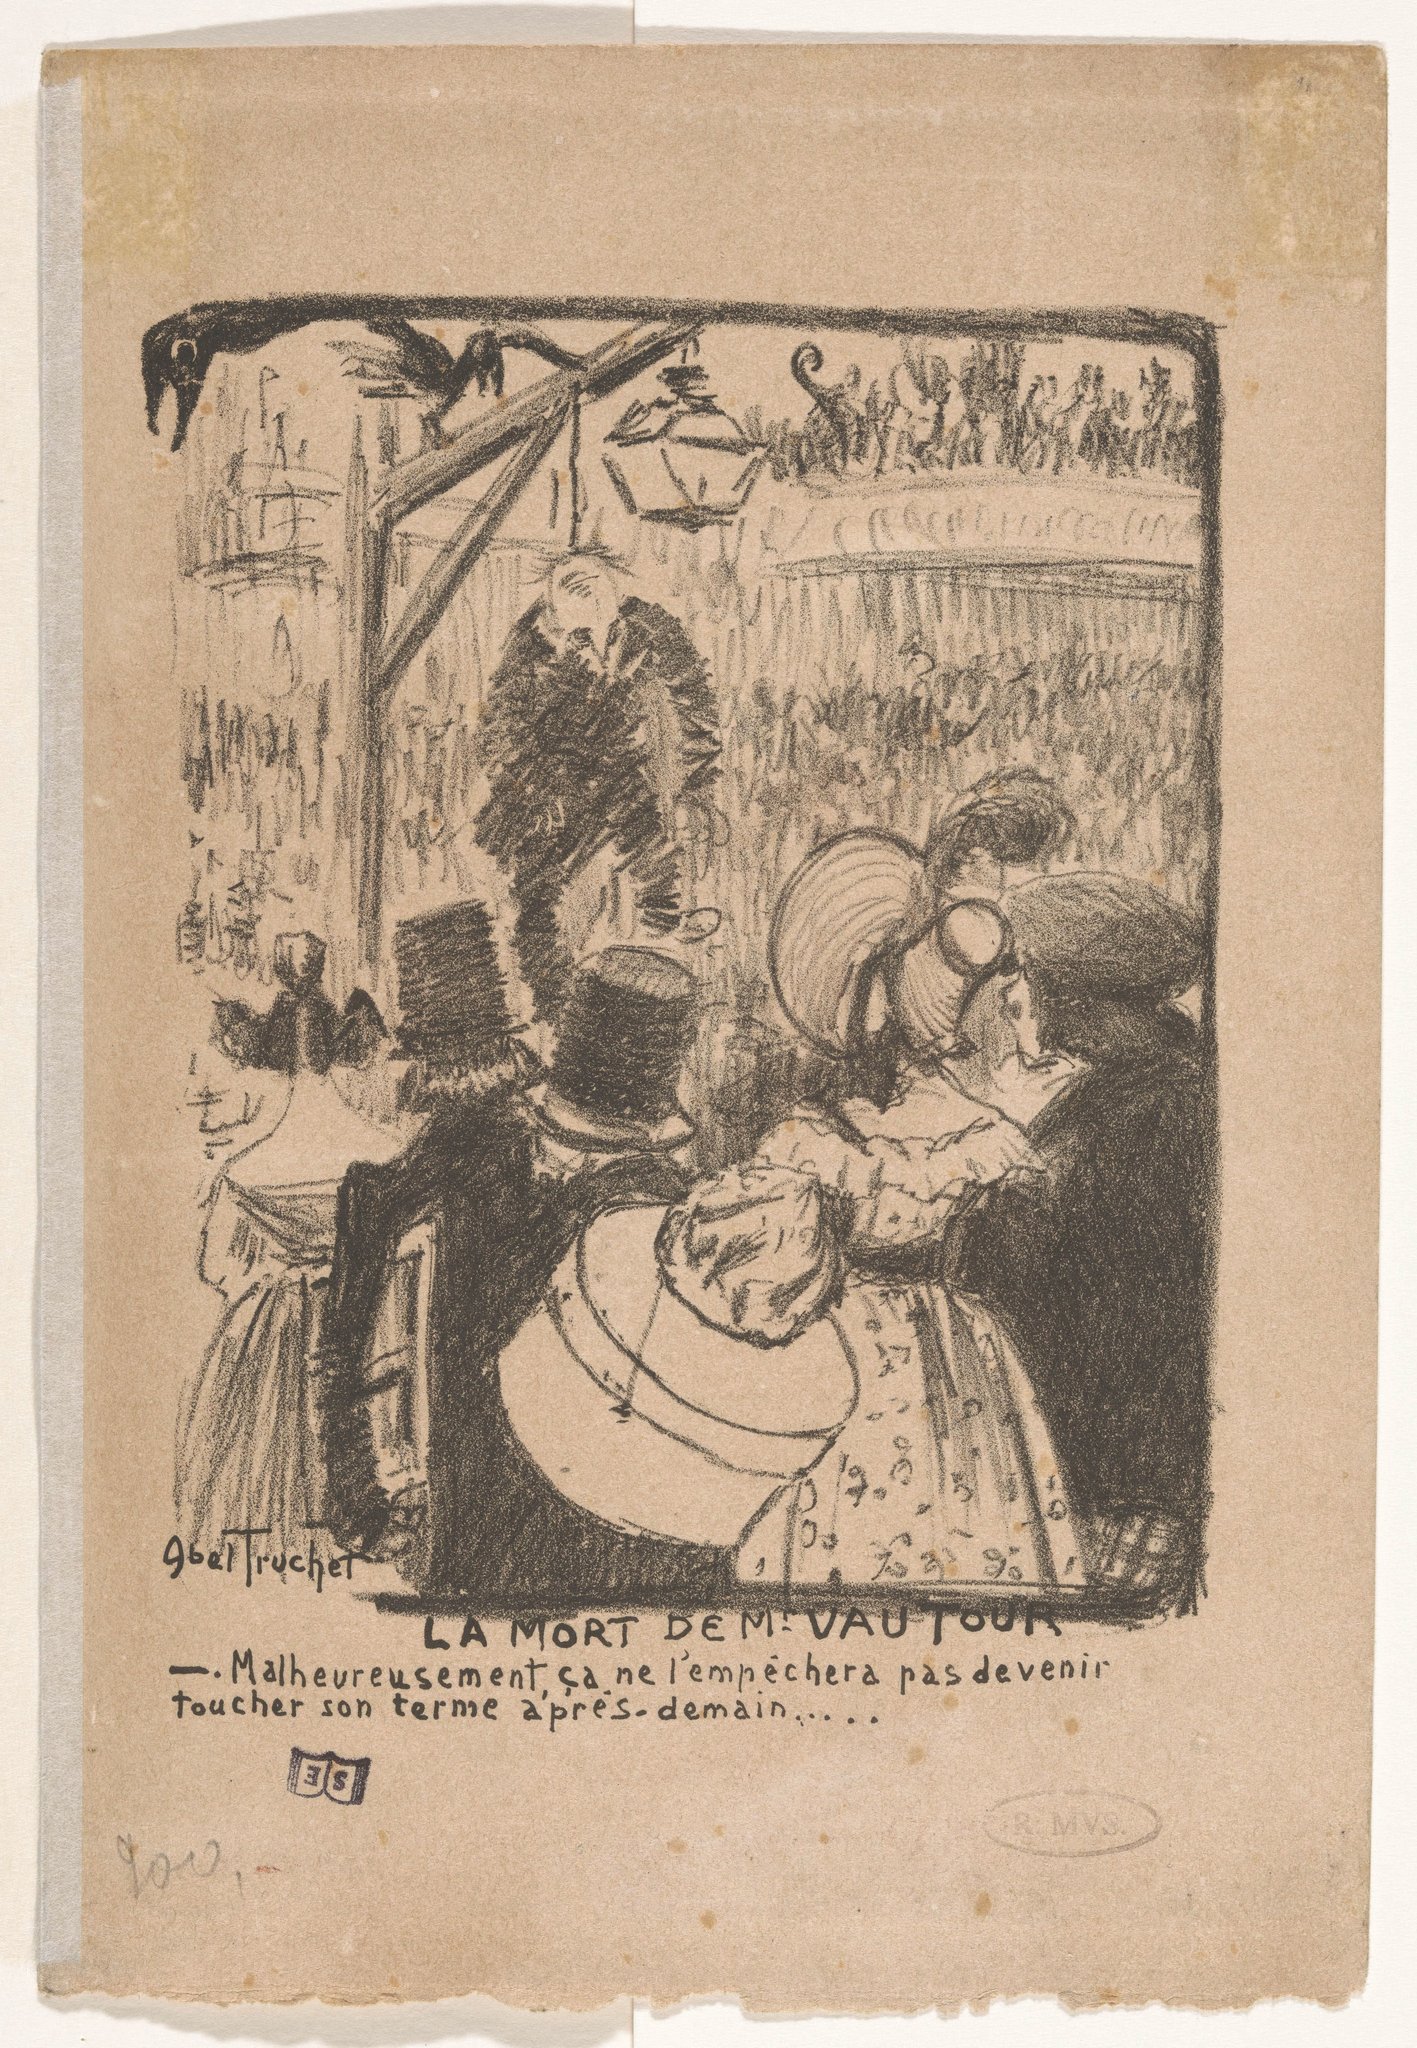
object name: print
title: La mort de mr. Vautour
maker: louis abel-truchet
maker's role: painter, print maker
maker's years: 1857-1918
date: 1867-1918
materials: paper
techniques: lithograph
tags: execution in effigy, political caricatures and satires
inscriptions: collector's mark: Lugt 4780, collector's mark: Lugt 2228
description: 'Monsieur Vautour' was een stereotype waarmee investeerders in vastgoed en huiseigenaren werden aangeduid. Mogelijk een illustratie uit een boek of tijdschrift.